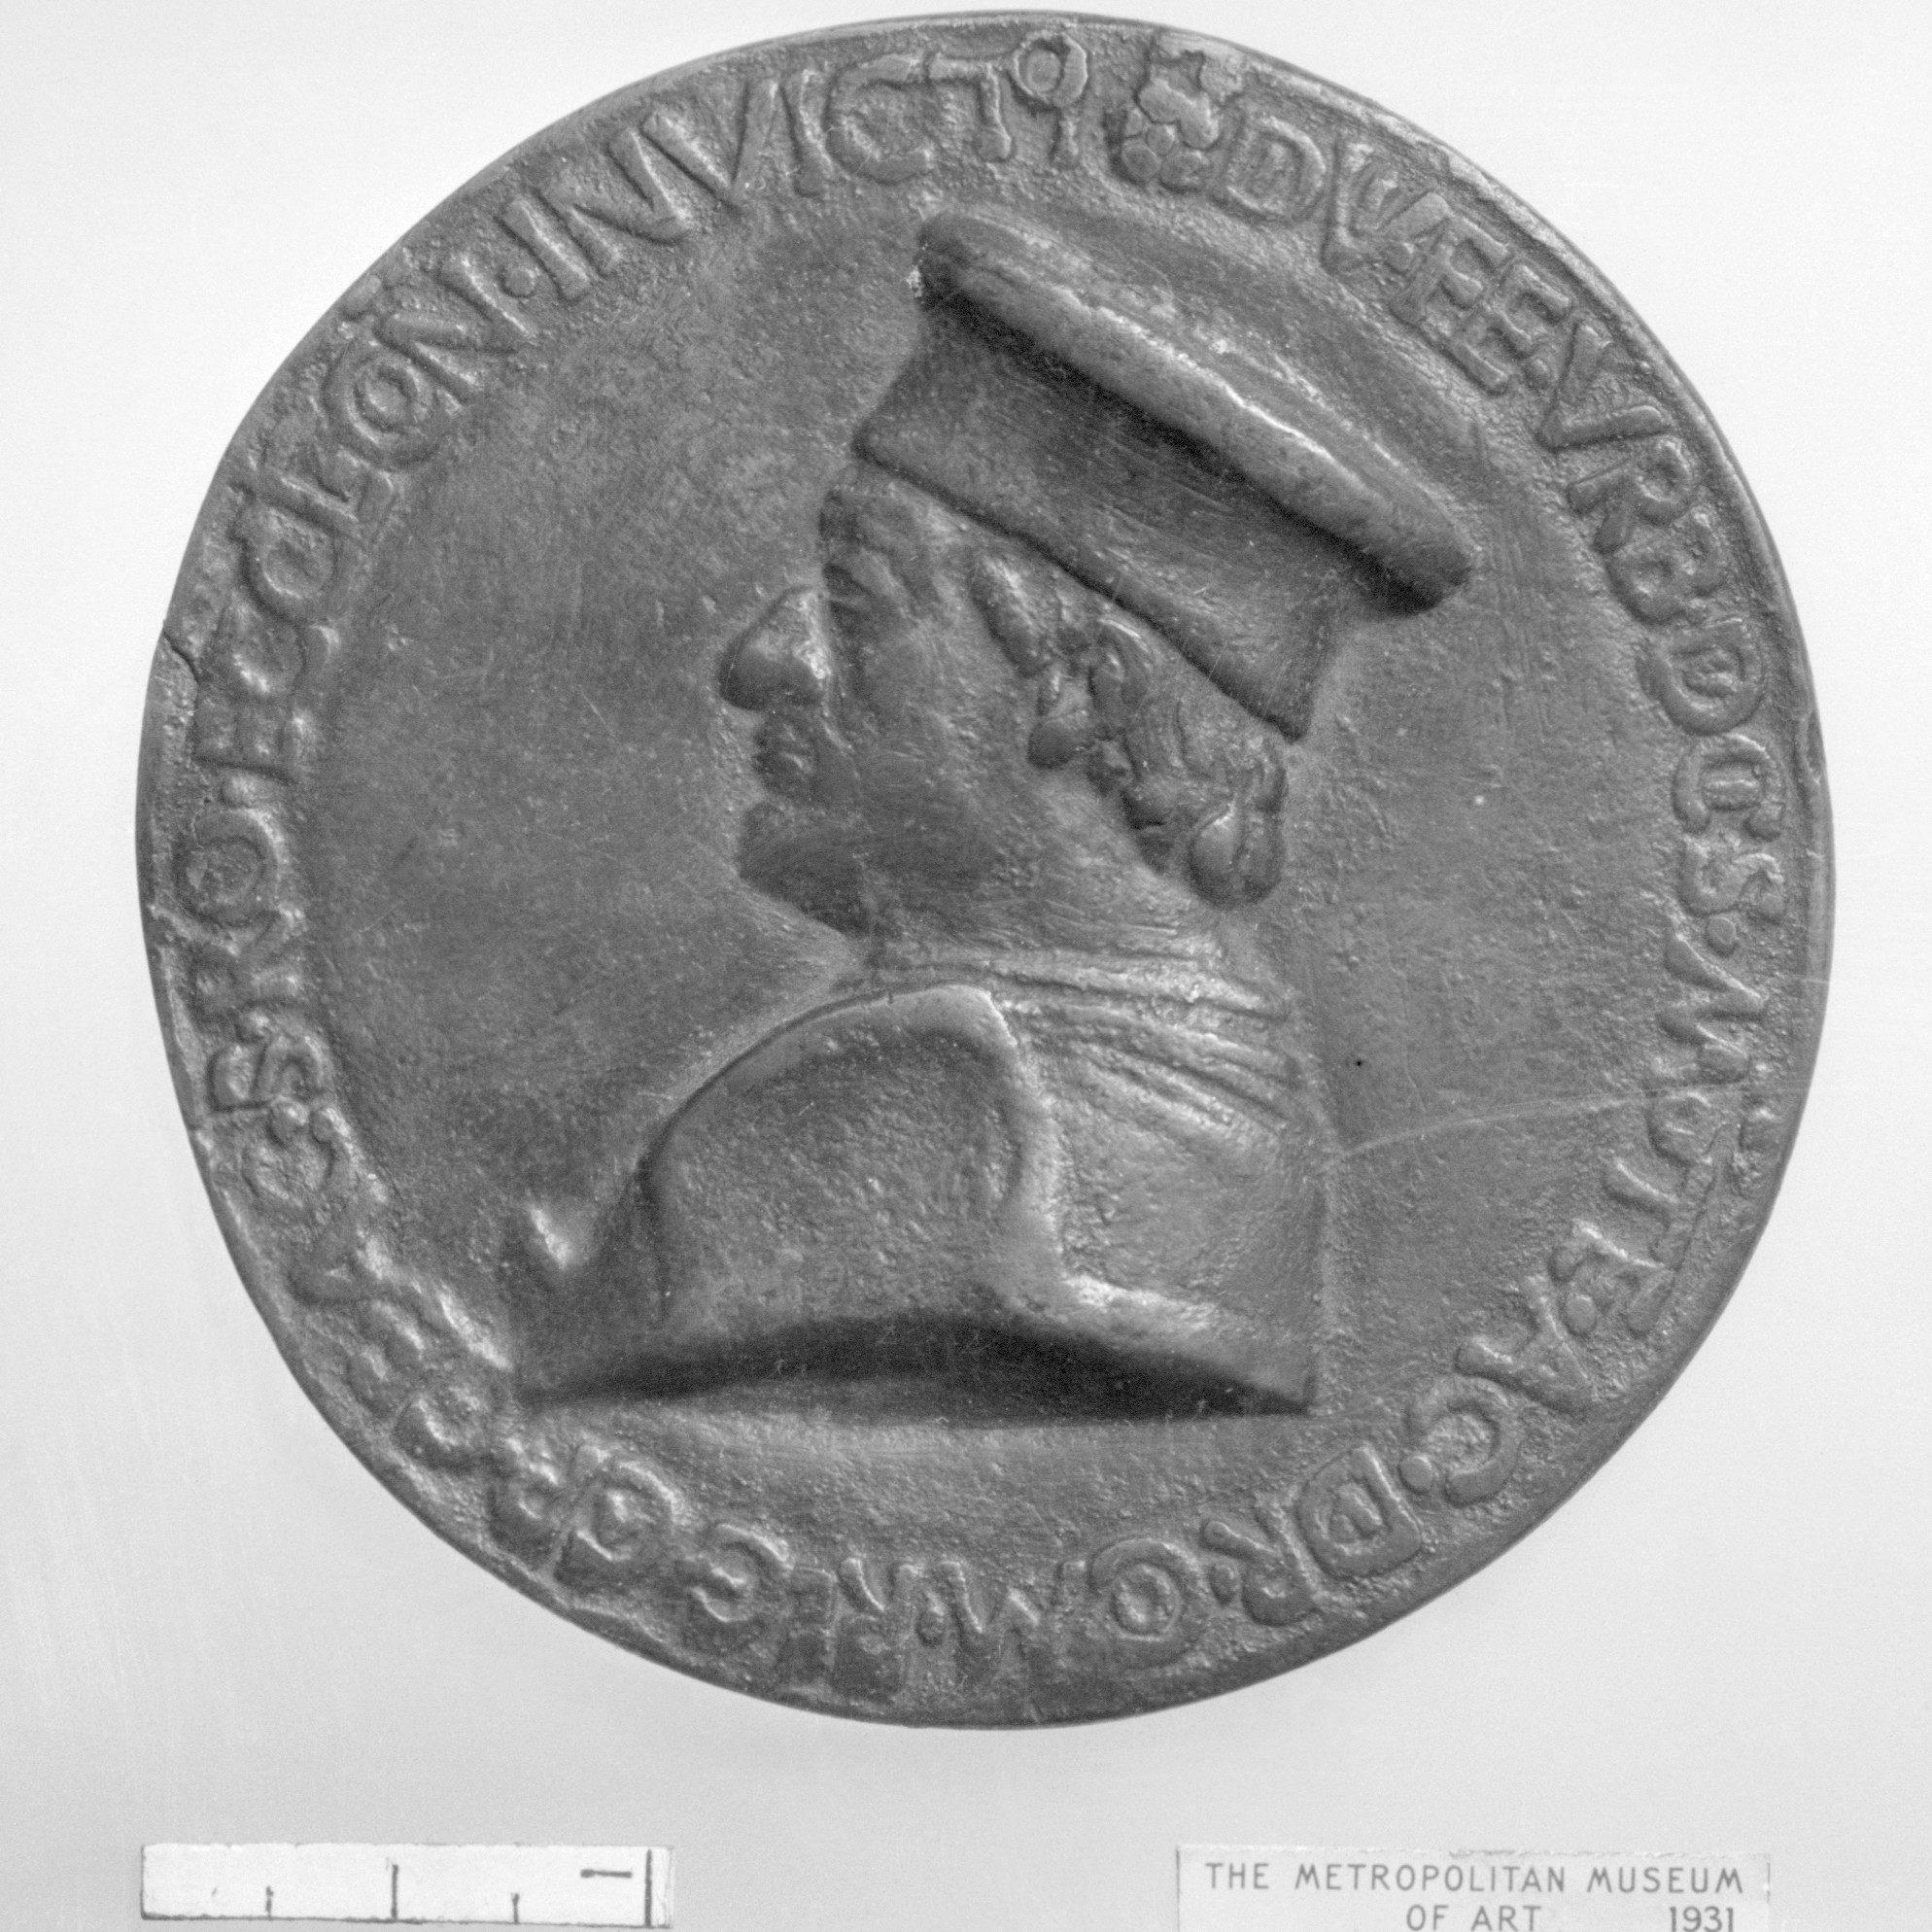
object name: medal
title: Federigo da Montefeltro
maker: savelli sperandio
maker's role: artist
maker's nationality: italian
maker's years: 1425-1504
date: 1474-1482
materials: bronze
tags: men,profiles,horses